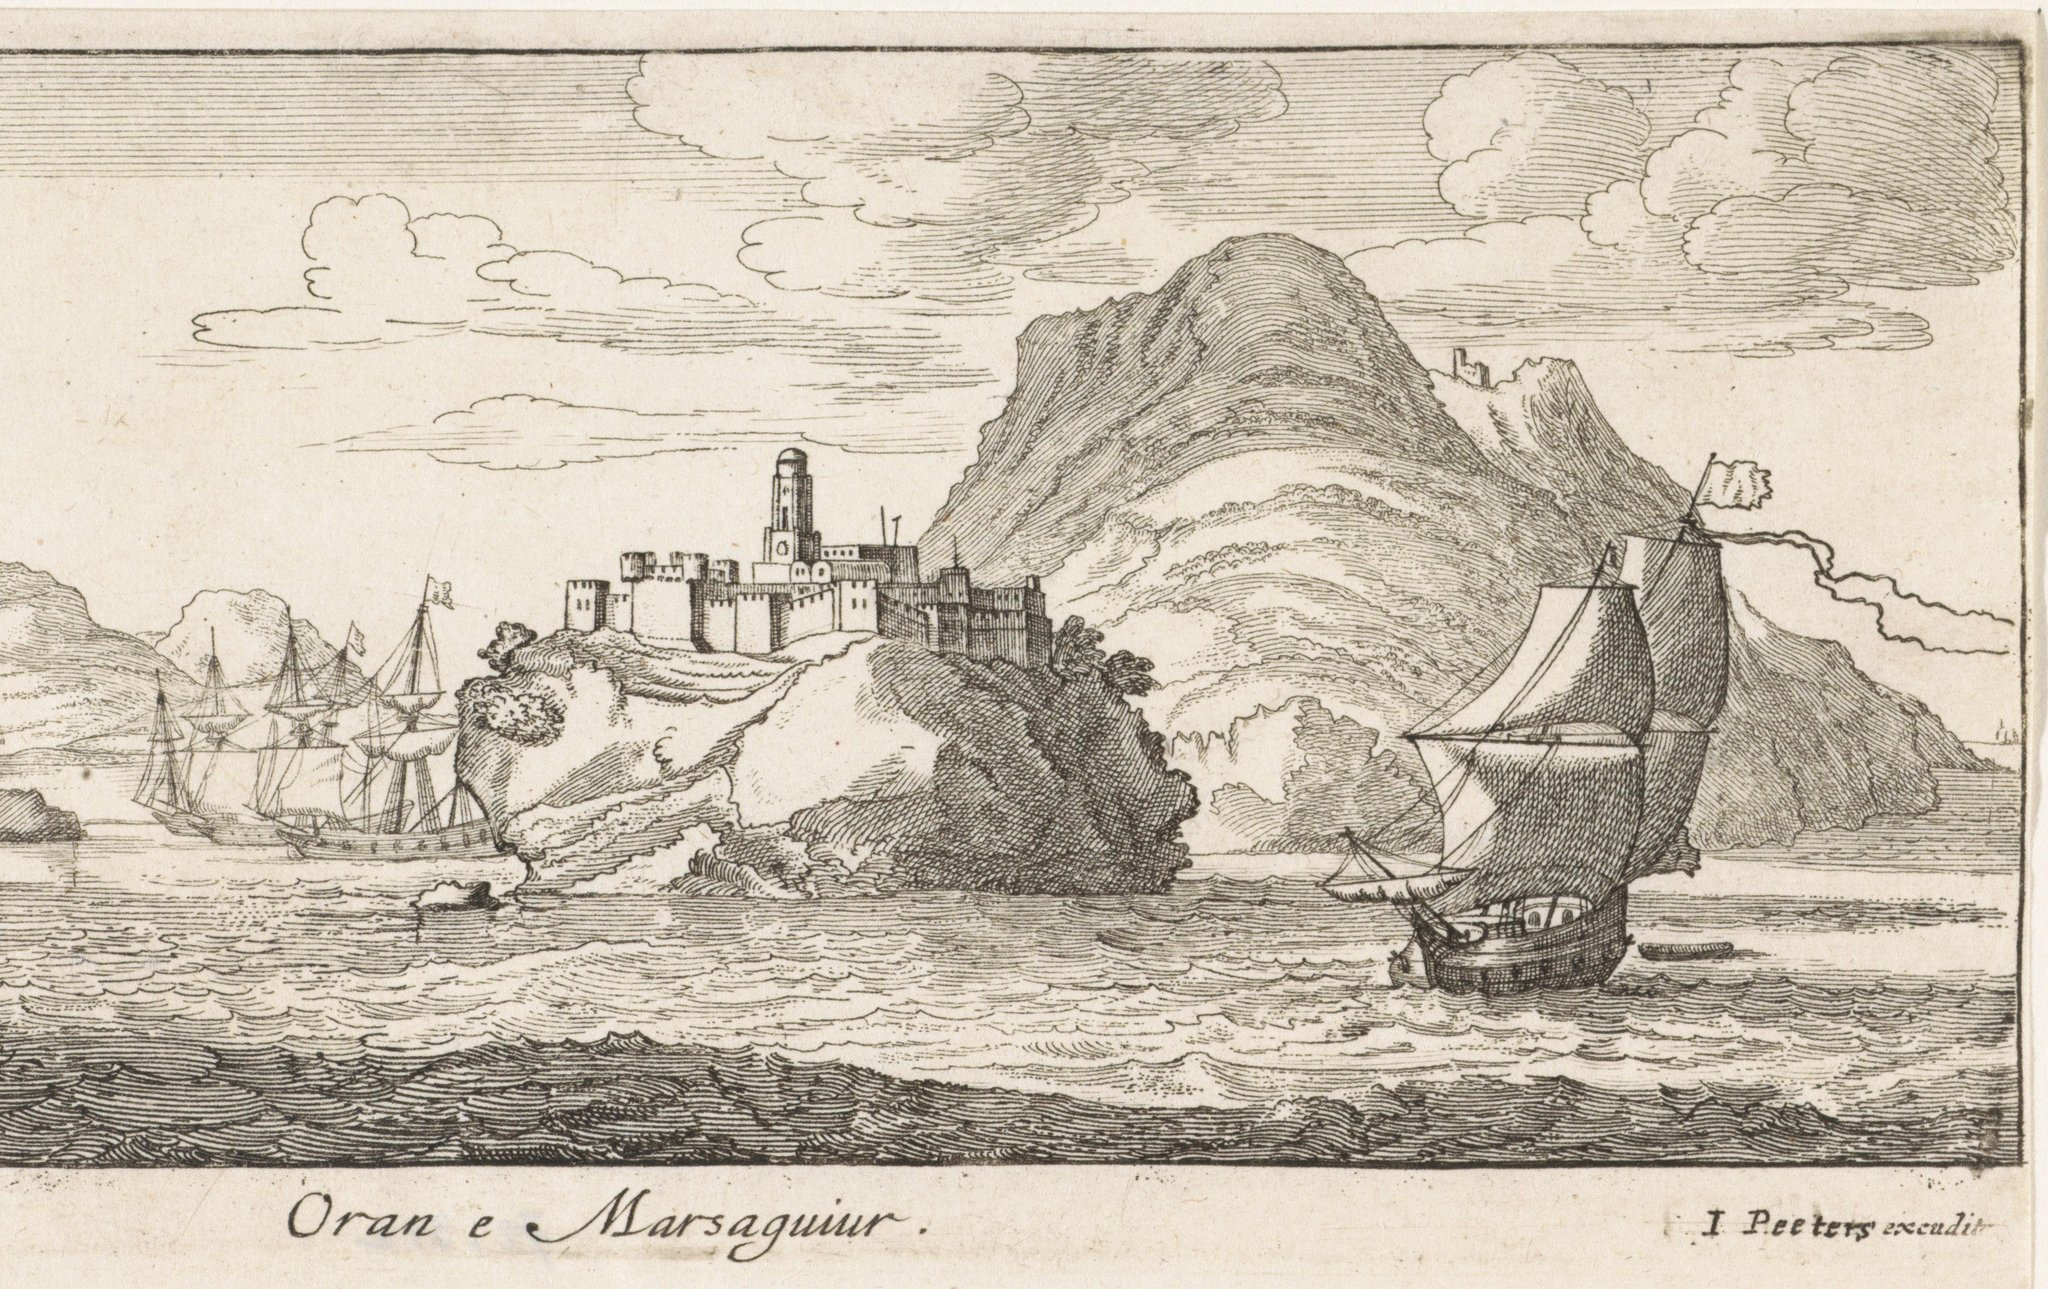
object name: print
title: Korte beschryvinghe, en de aen-wysinghe der plaetsen in desen boeck[(...)]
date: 1683-1685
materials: paper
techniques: etching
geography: antwerp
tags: harbour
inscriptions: collector's mark: Lugt 2228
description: Prent gebruikt in: Description des principales villes, havres et isles du golfe de Venise du cote oriental, comme aussi des villes et fortresses de la Moree et quelques places de la Grece et es isles principales de l'Archipel et fortresses dícelles et en suittes quelques places renommées de la Terre Saincte, et autres dessous la domination Ottomane vers le Midij et l'Orient, et quelques principales villes en Perse et le regne du Grand Mogol le tout en Abrege. Antwerpen: Jacob Peeters, s.a.